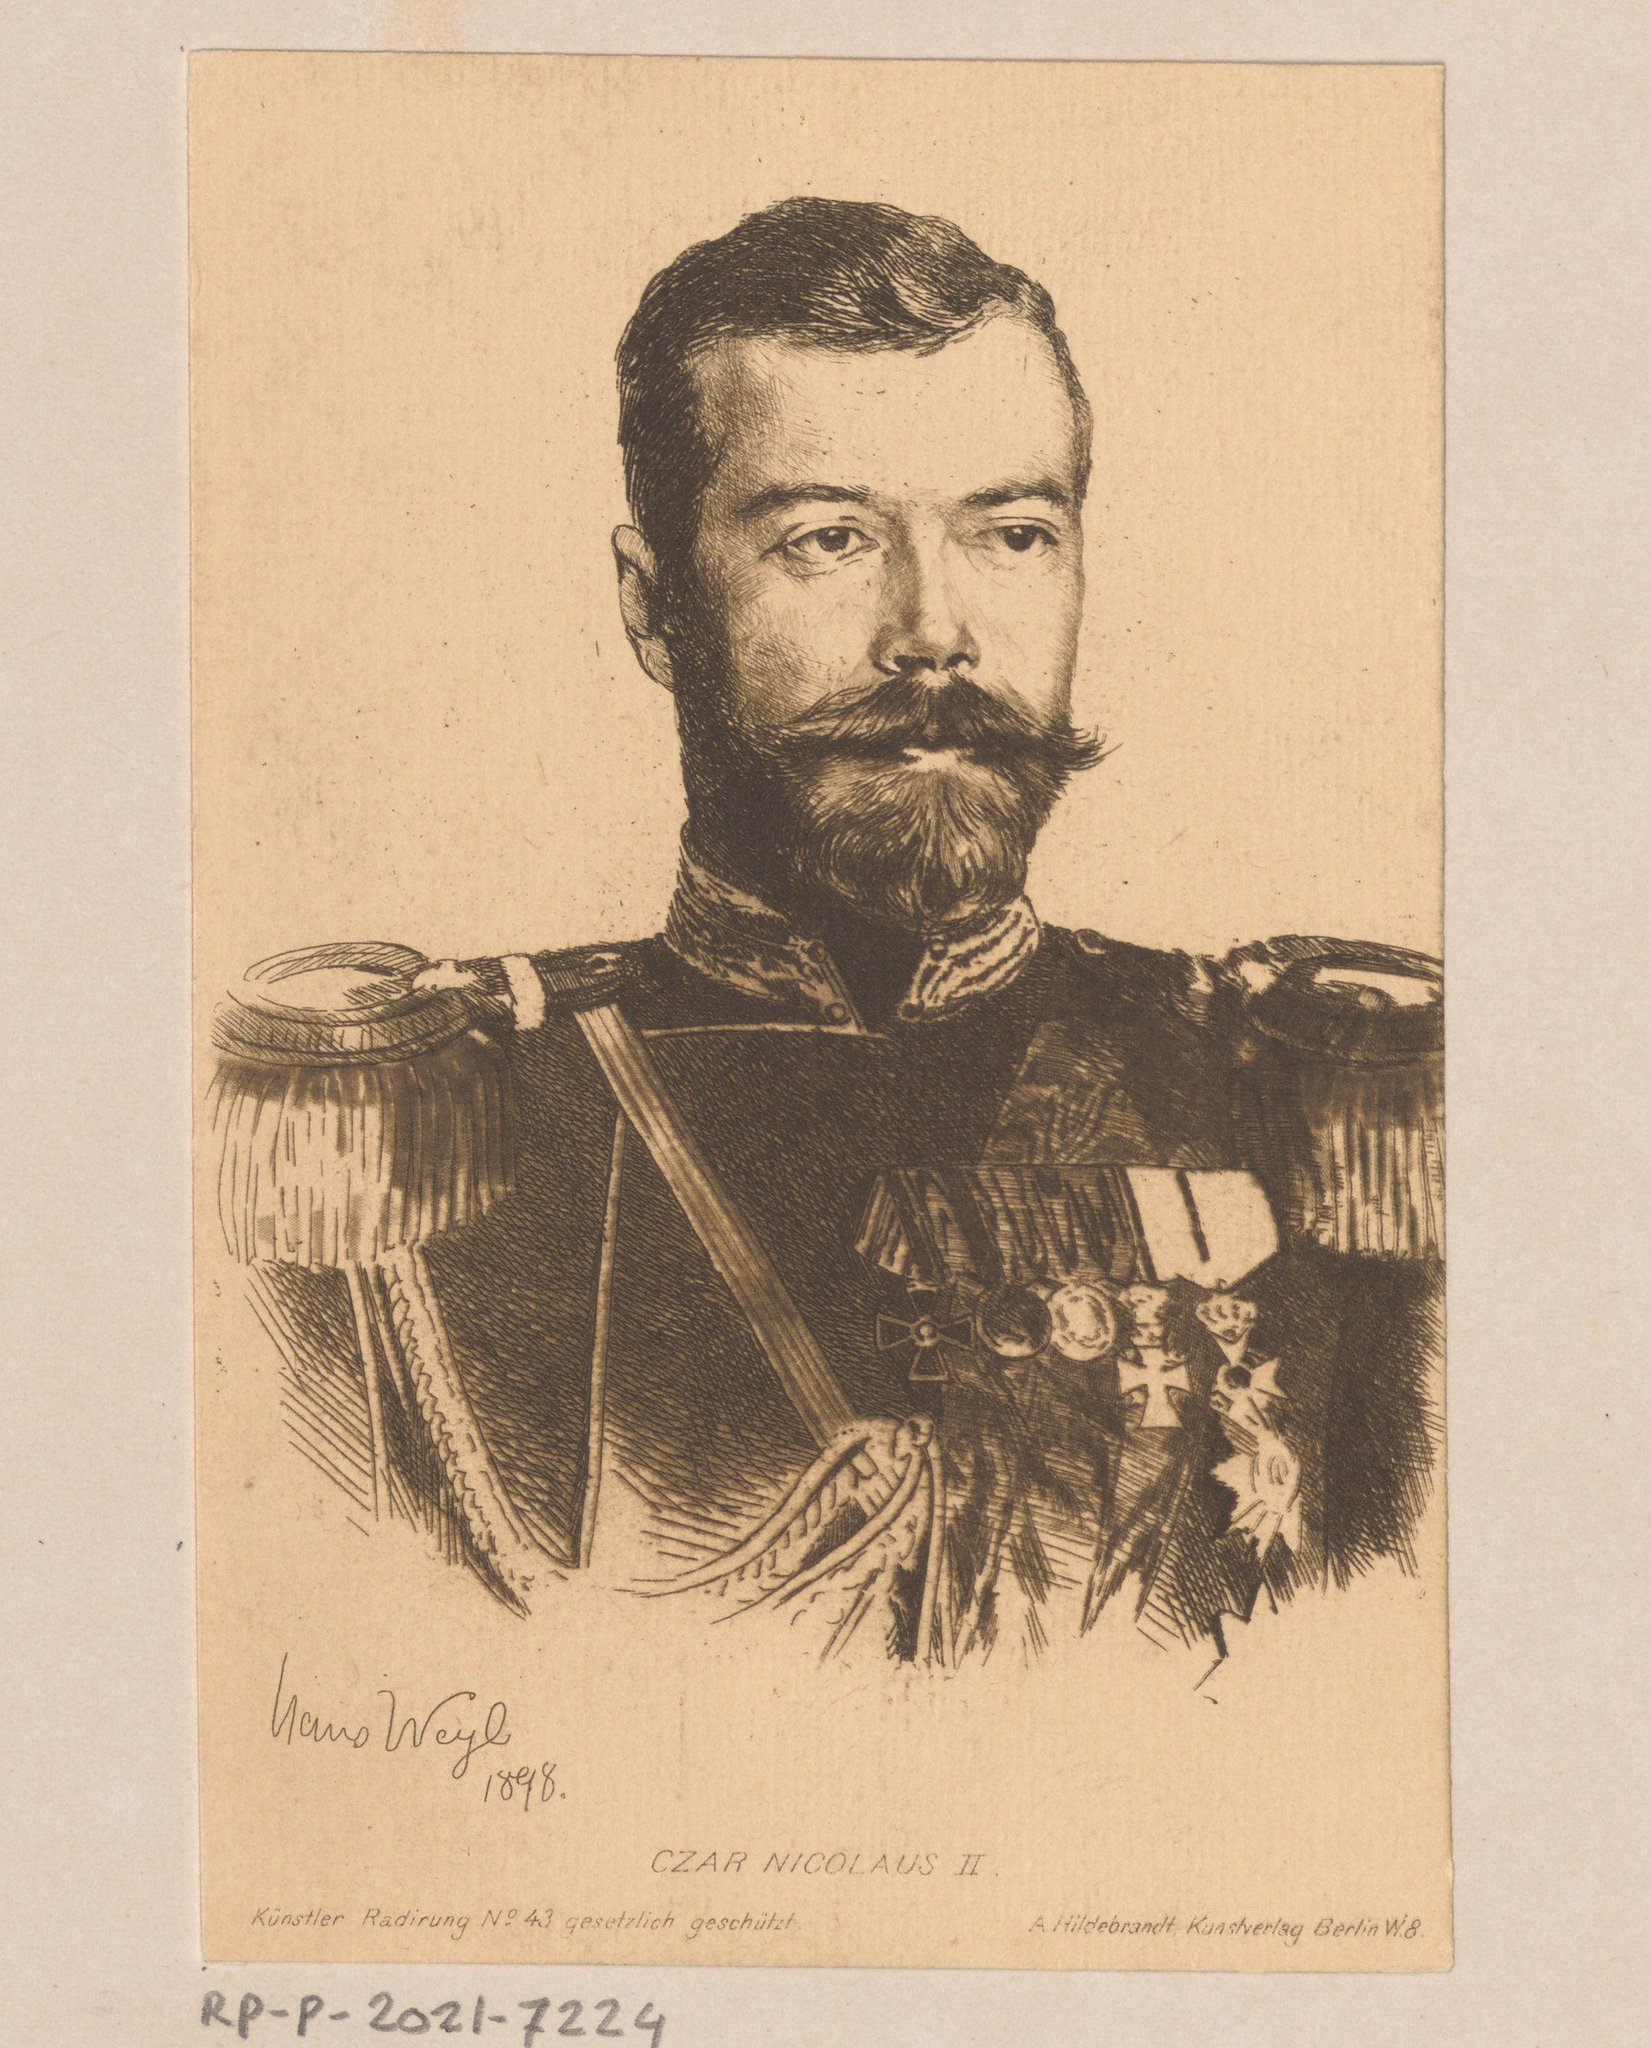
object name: print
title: Czar Nicolaus II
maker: hans weyl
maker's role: painter, print maker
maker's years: 1863-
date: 1898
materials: cardboard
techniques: etching, retroussage, roulette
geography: berlin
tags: historical persons, ruler, sovereign